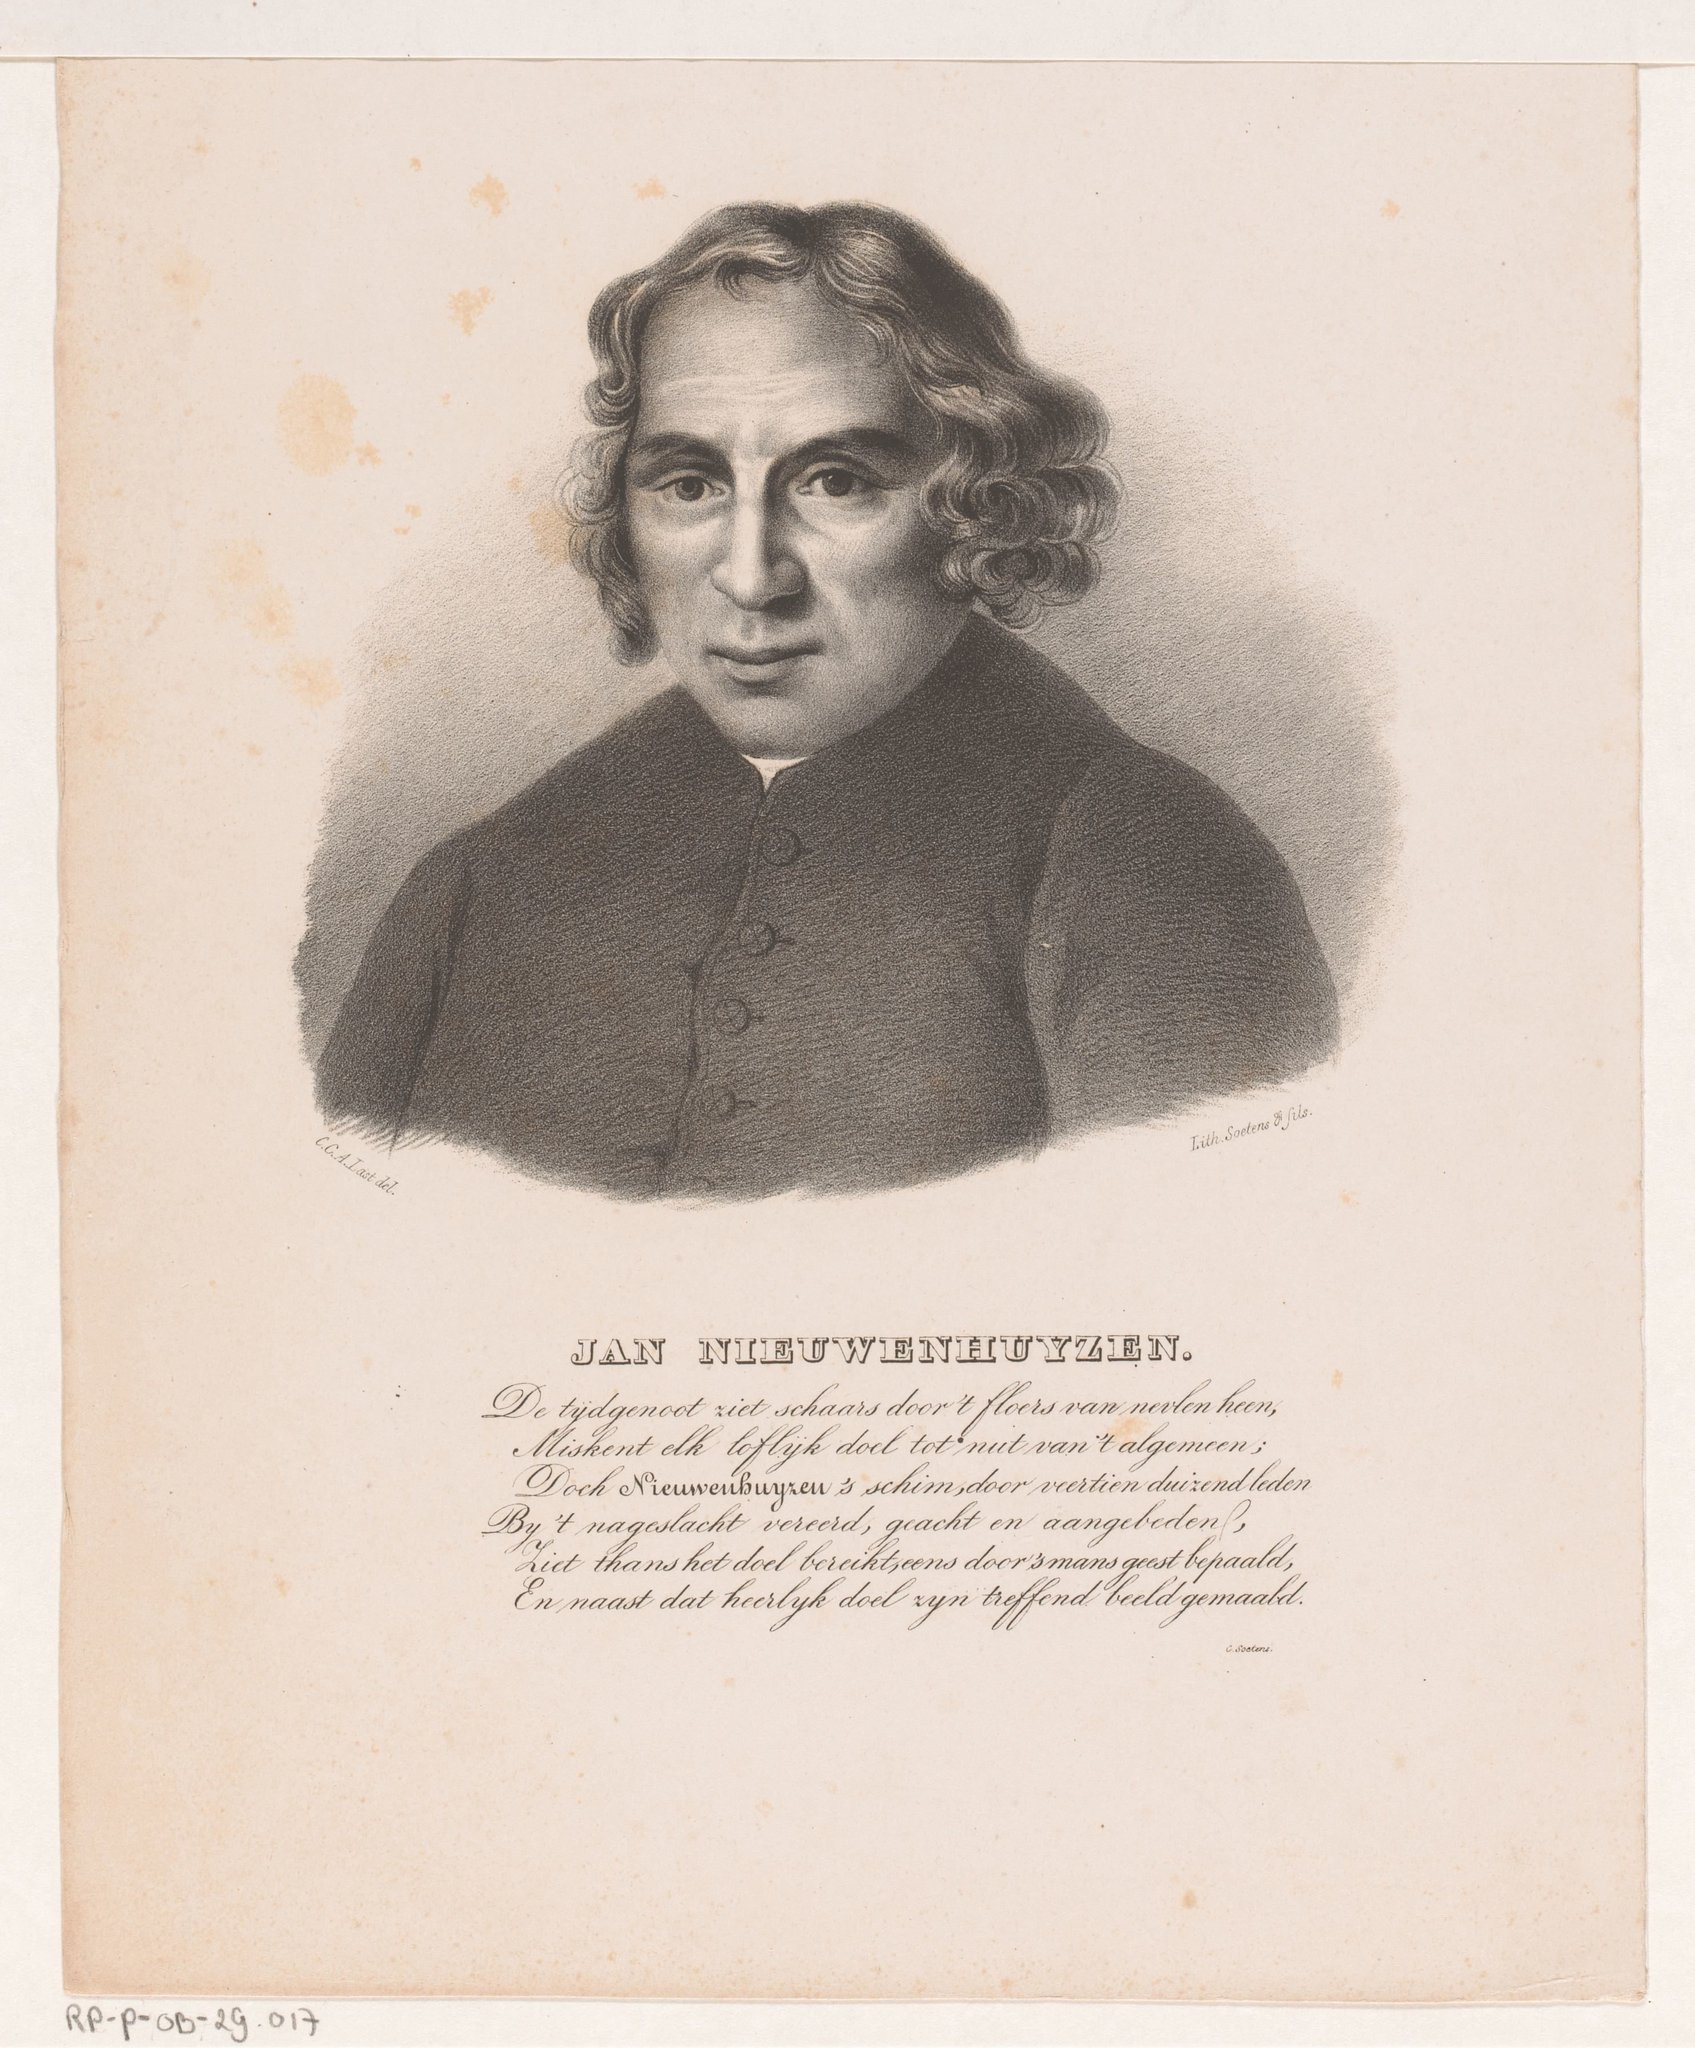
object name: print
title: Portret van Jan Nieuwenhuyzen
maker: carel christiaan antony last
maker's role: print maker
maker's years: 1808-1876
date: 1837-1840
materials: paper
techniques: lithograph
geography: the hague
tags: haarlem, amsterdam, jan nieuwenhuyzen, historical persons (+ (full) bust portrait)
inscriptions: collector's mark: Lugt 2228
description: Onder het portret een zesregelig onderschrift door C. Soetens.